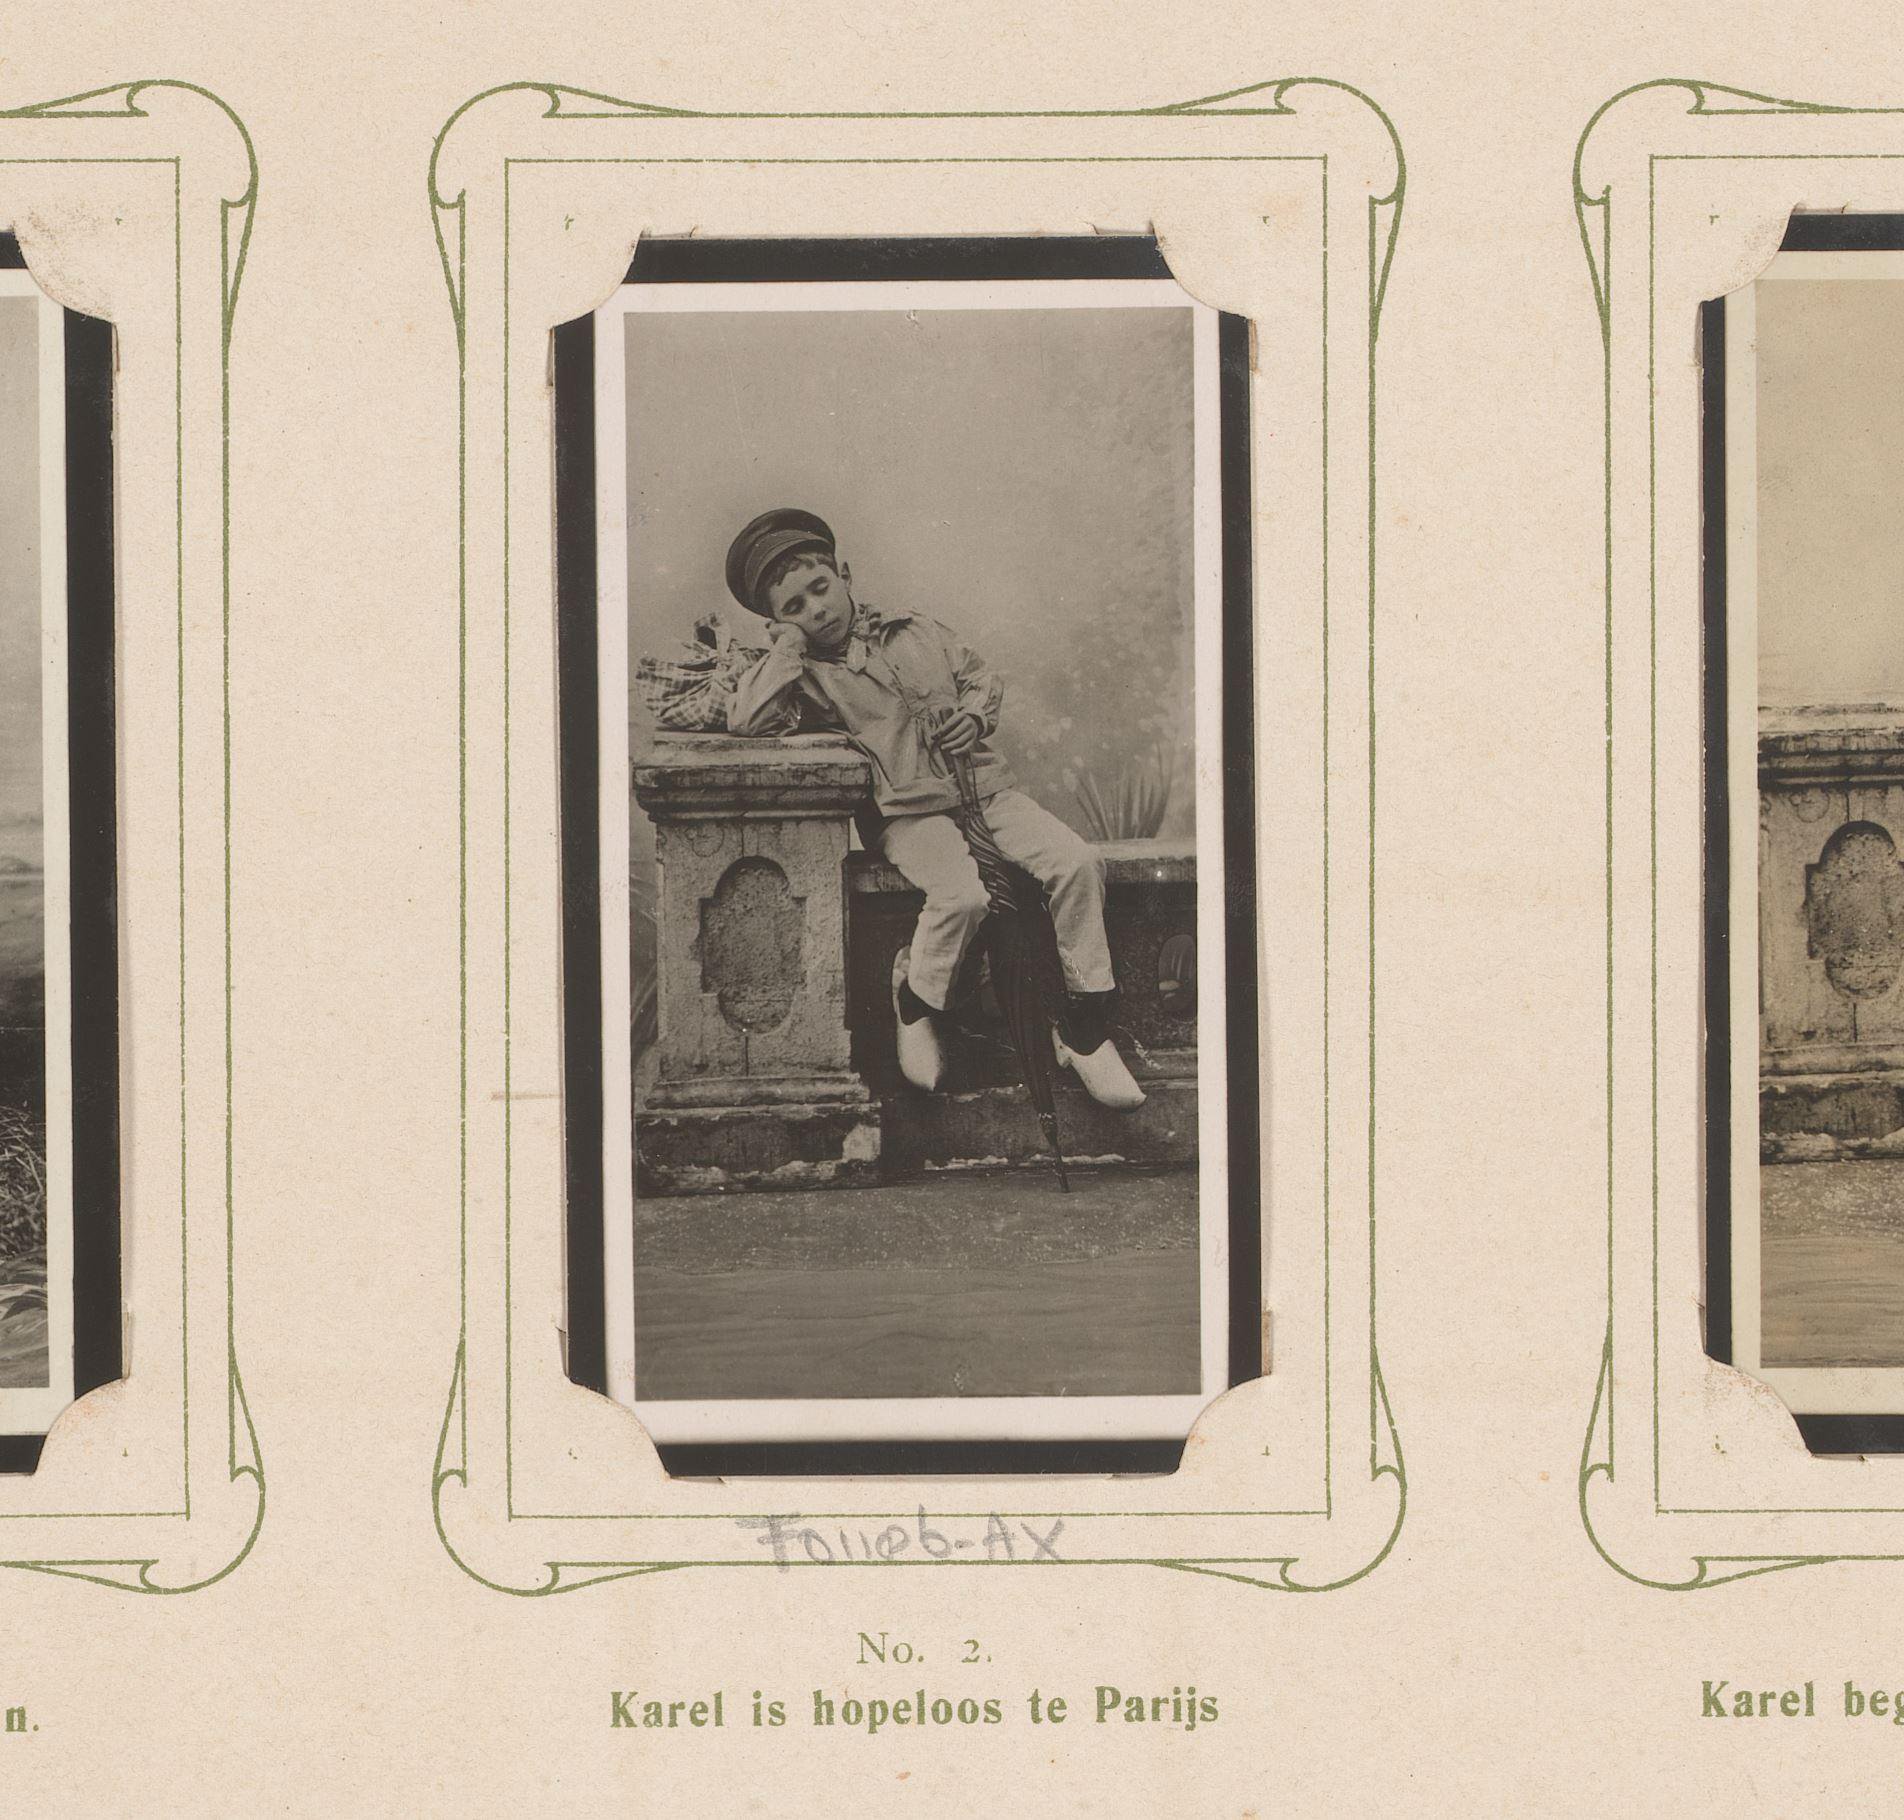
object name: album leaf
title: Zittende jongen met een paraplu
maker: Anonymous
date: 1904-1905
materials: photographic support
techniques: gelatin silver print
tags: boy (child between toddler and youth), umbrella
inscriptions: inscription: ‘No. 2./ Karel is hopeloos te Parijs’